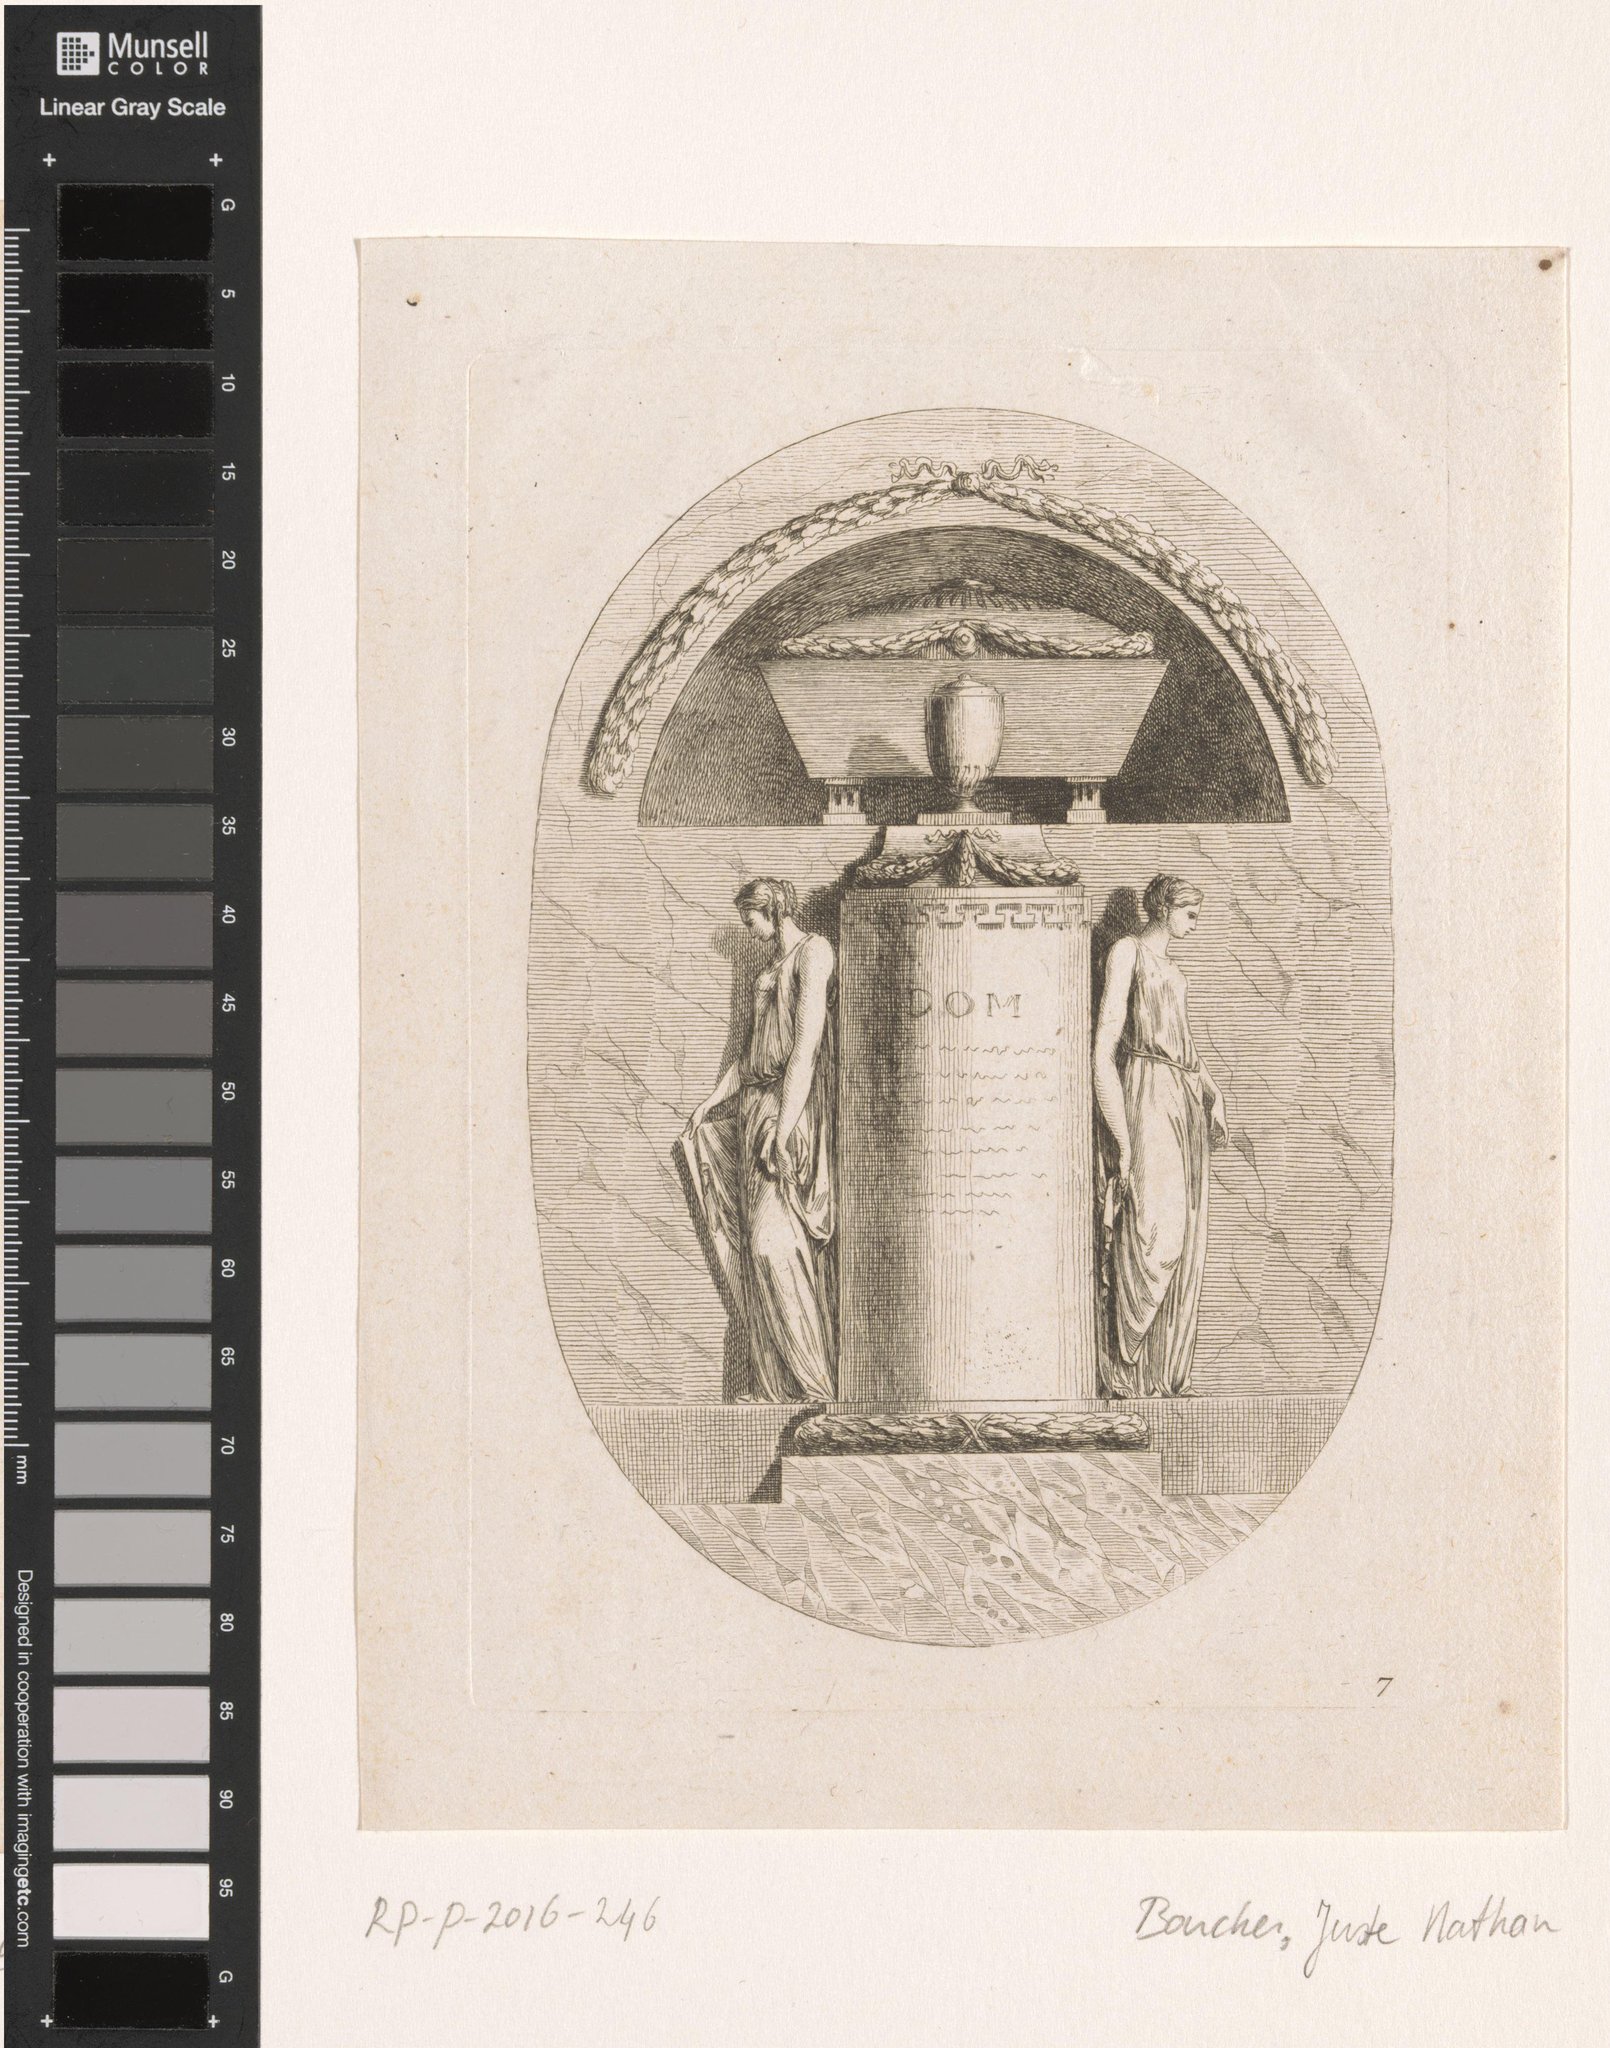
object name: ornament print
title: Livre De tombeaux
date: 1755-1782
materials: paper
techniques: etching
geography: paris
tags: niche-tomb, wall-tomb, column, pillar ~ architecture, standing figure - aa - female human figure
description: Een tombe in een halfronde nis, daarvoor flankeren twee staande vrouwen een zuil.